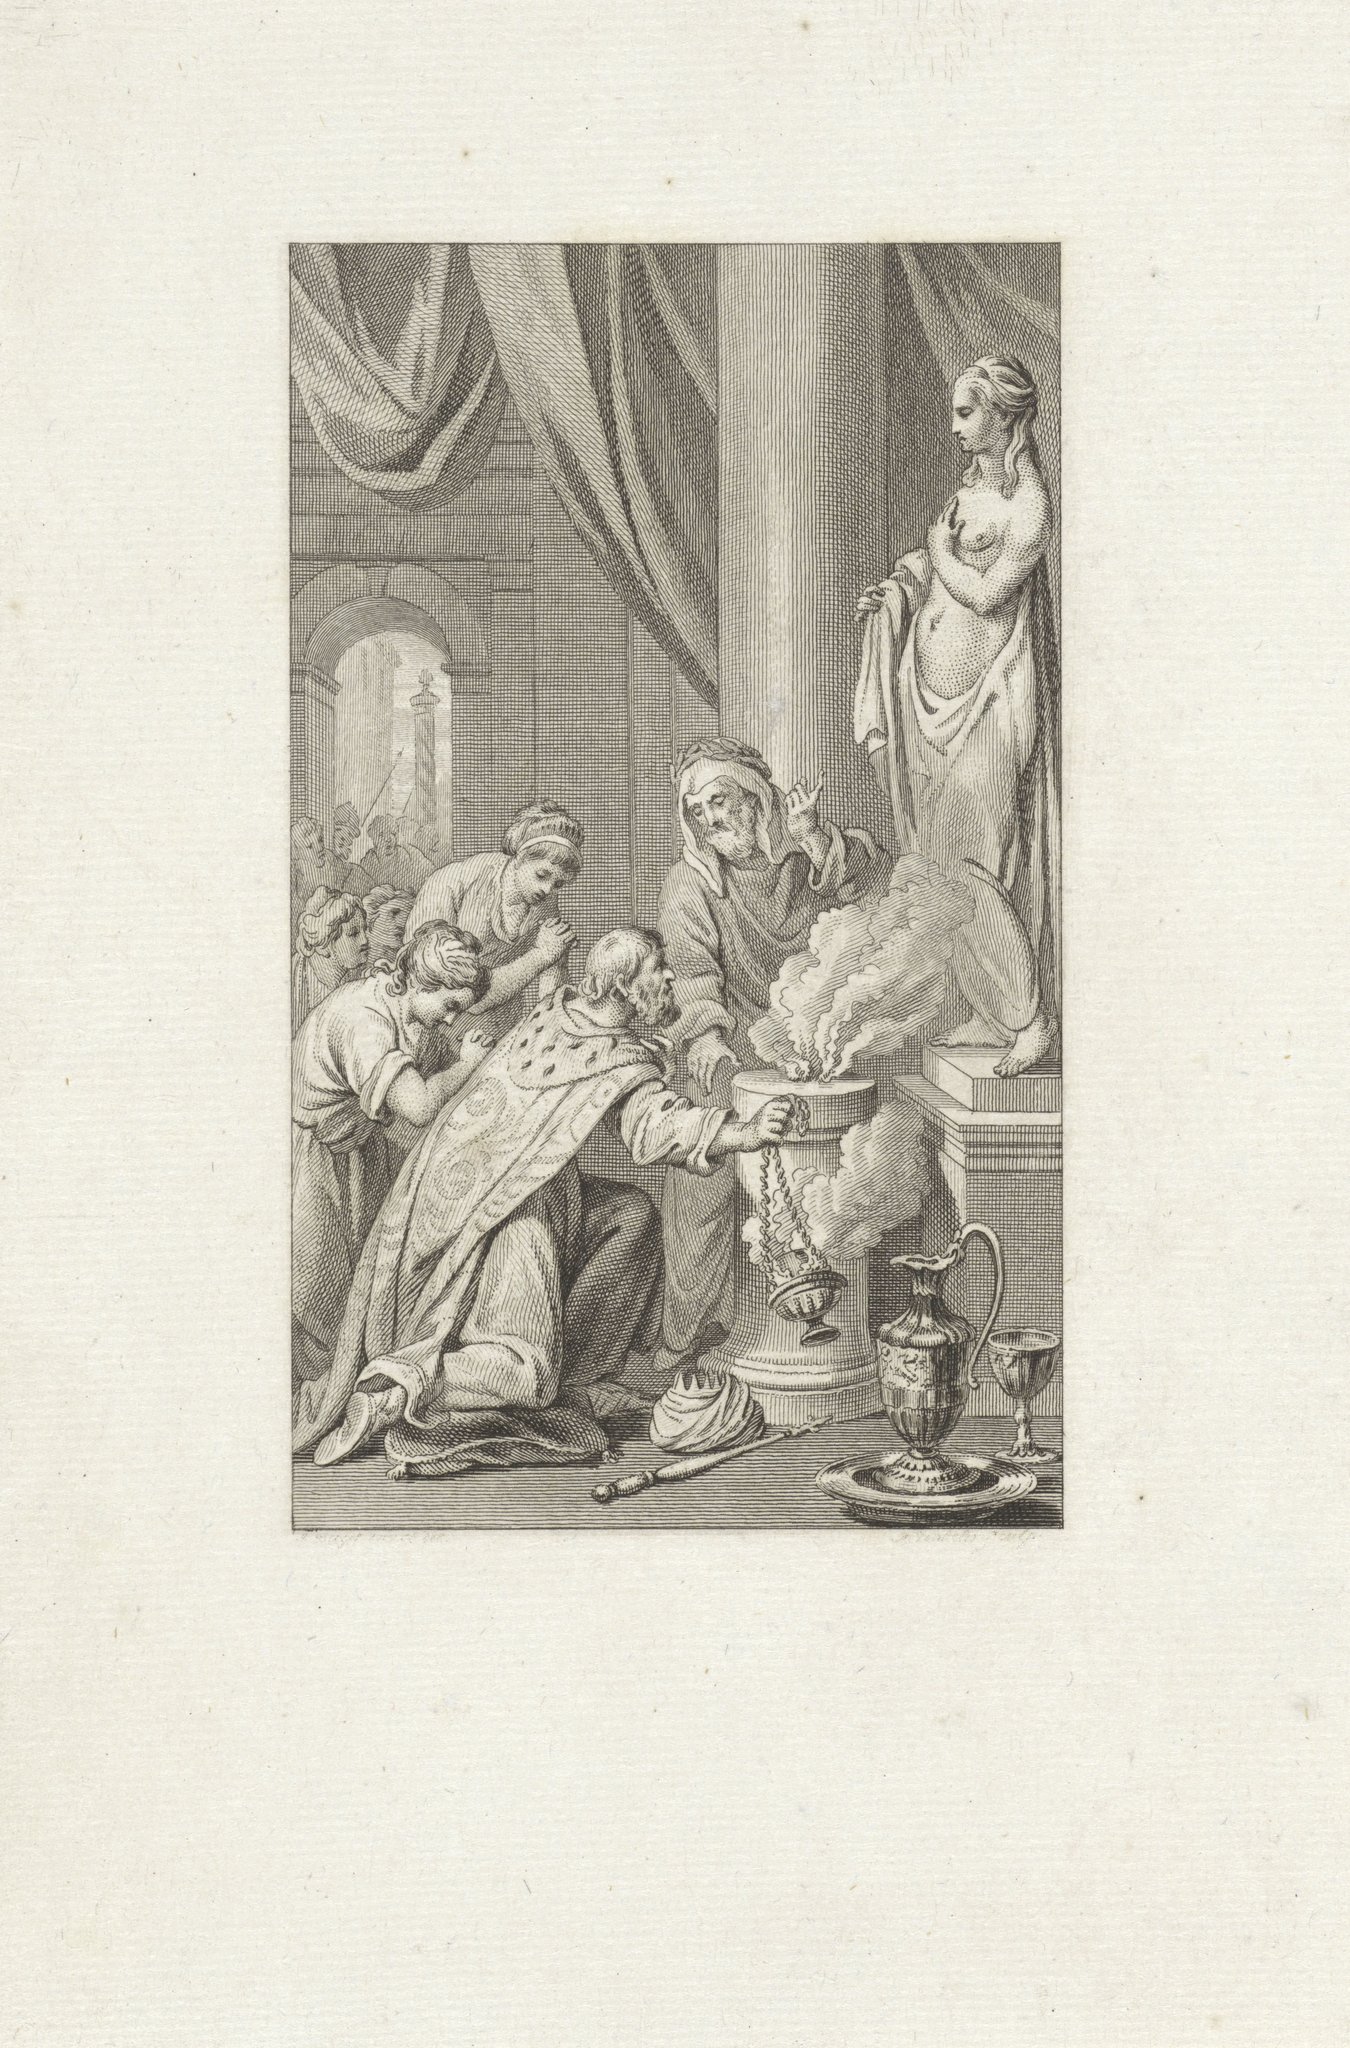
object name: print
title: Afgoderij van Salomo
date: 1797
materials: paper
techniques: engraving, etching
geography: amsterdam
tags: solomon offers sacrifices to pagan gods (sometimes idols and/or a golden calf upon the altar)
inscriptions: collector's mark: Lugt 240